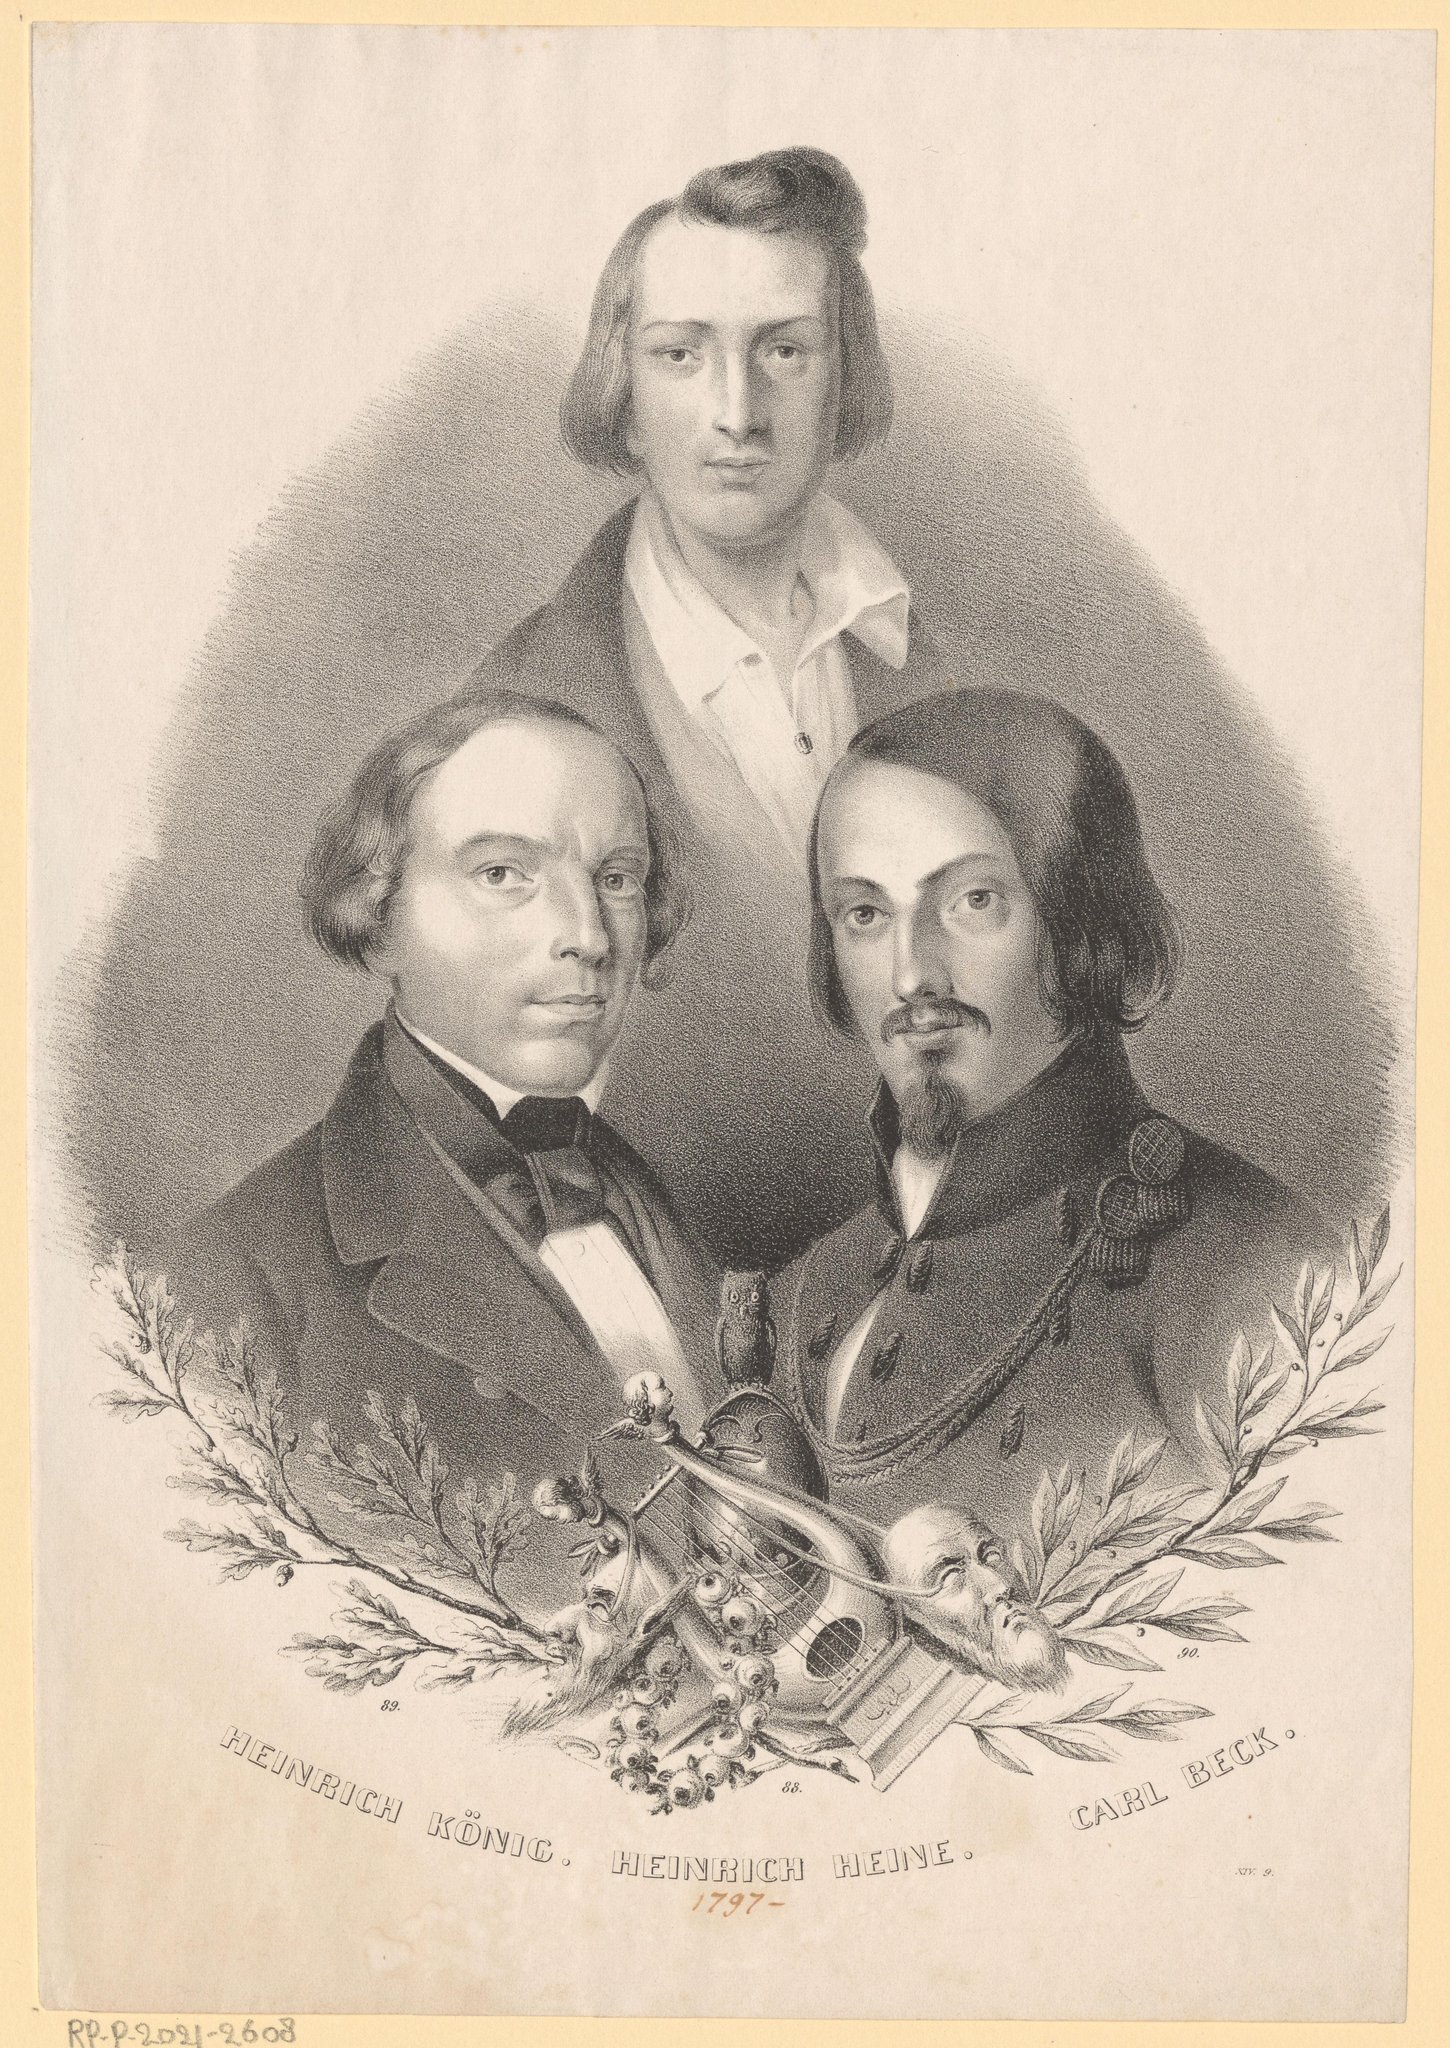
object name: print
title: Portretten van Heinrich Joseph König, Heinrich Heine en Karl Isidor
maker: Anonymous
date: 1850-1899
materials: paper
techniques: lithograph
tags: paris, heinrich heine, vienna, heinrich joseph könig, mask, historical persons, harp, portrait of actor, actress, trees: oak (+ branch, stick)